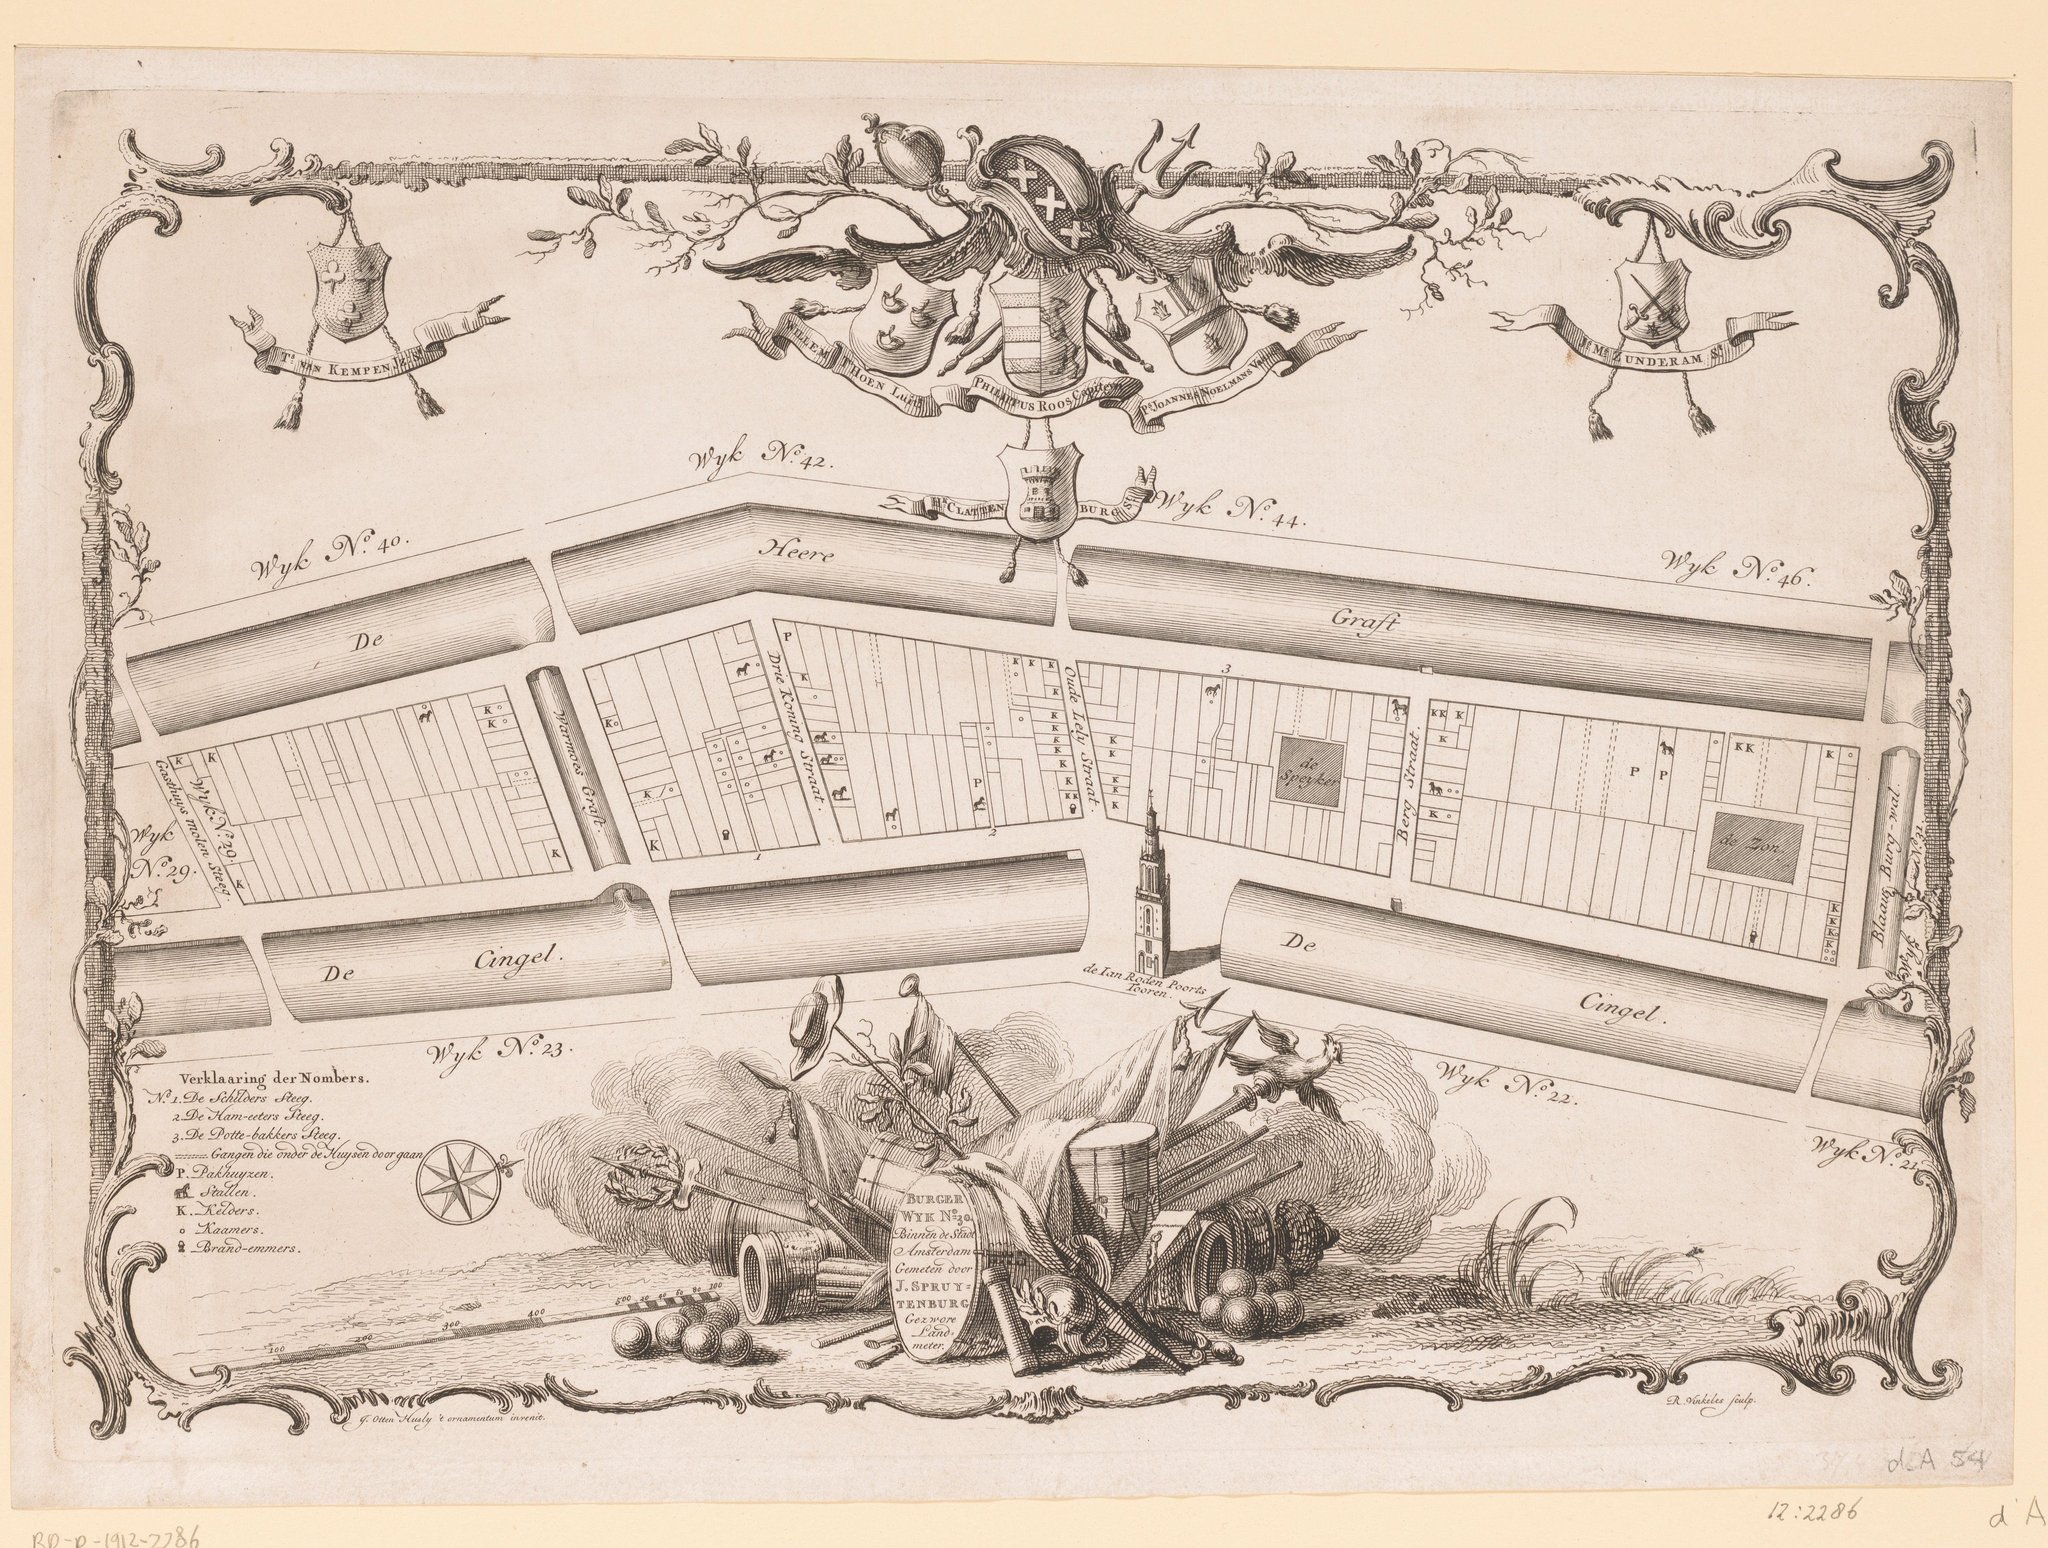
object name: print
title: Plattegrond van burgerwijk XXX te Amsterdam, onder leiding van kapitein Philippus Roos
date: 1751-1795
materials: paper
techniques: etching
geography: amsterdam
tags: tower, clock tower ~ monumental adornment, maps of cities, armorial bearing, heraldry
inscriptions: collector's mark: Lugt 2228